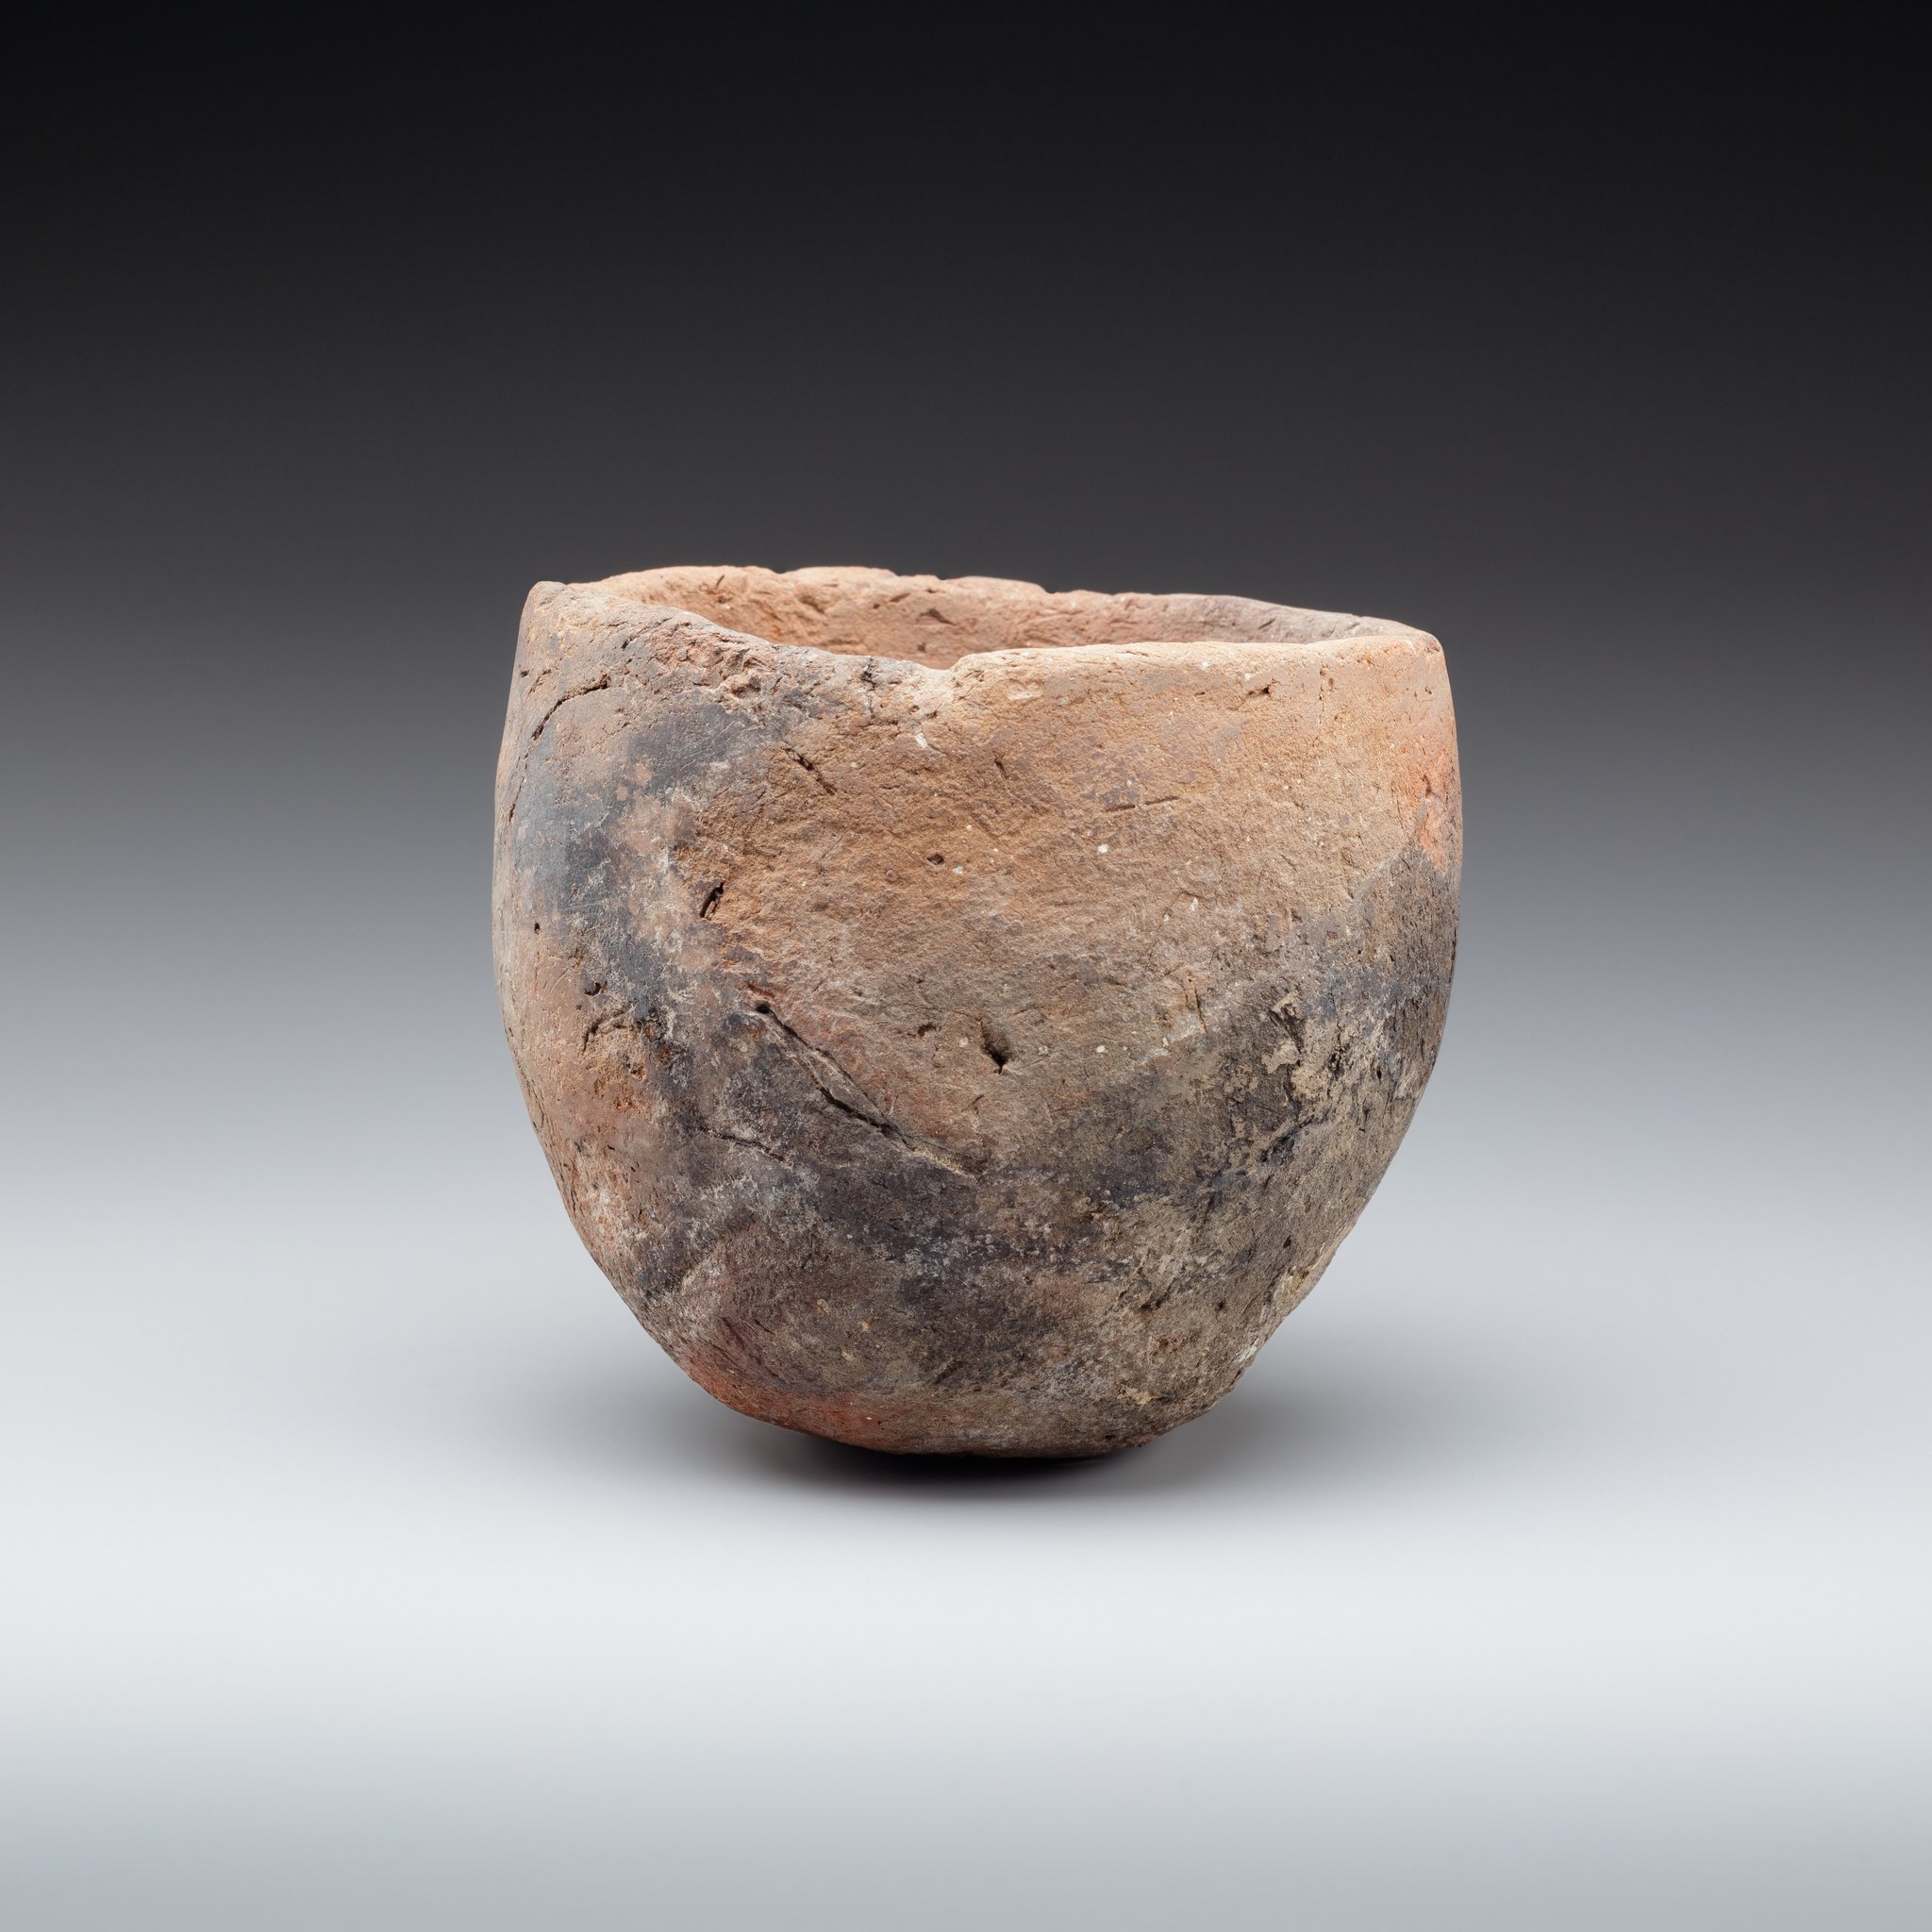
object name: bowl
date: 4500-4000 BCE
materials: pottery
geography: egypt